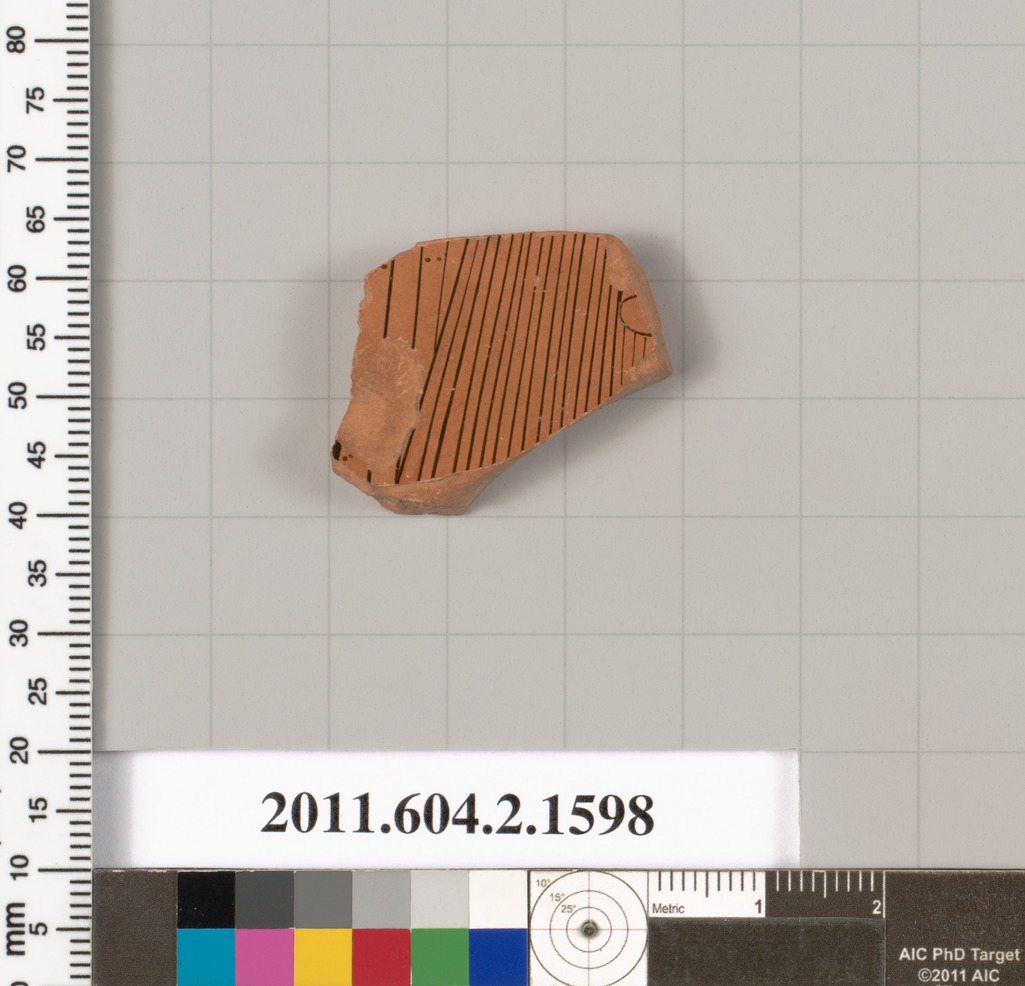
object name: skyphos fragment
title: Terracotta fragment of a skyphos (deep drinking cup)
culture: greek, attic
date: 475-451 BCE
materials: terracotta